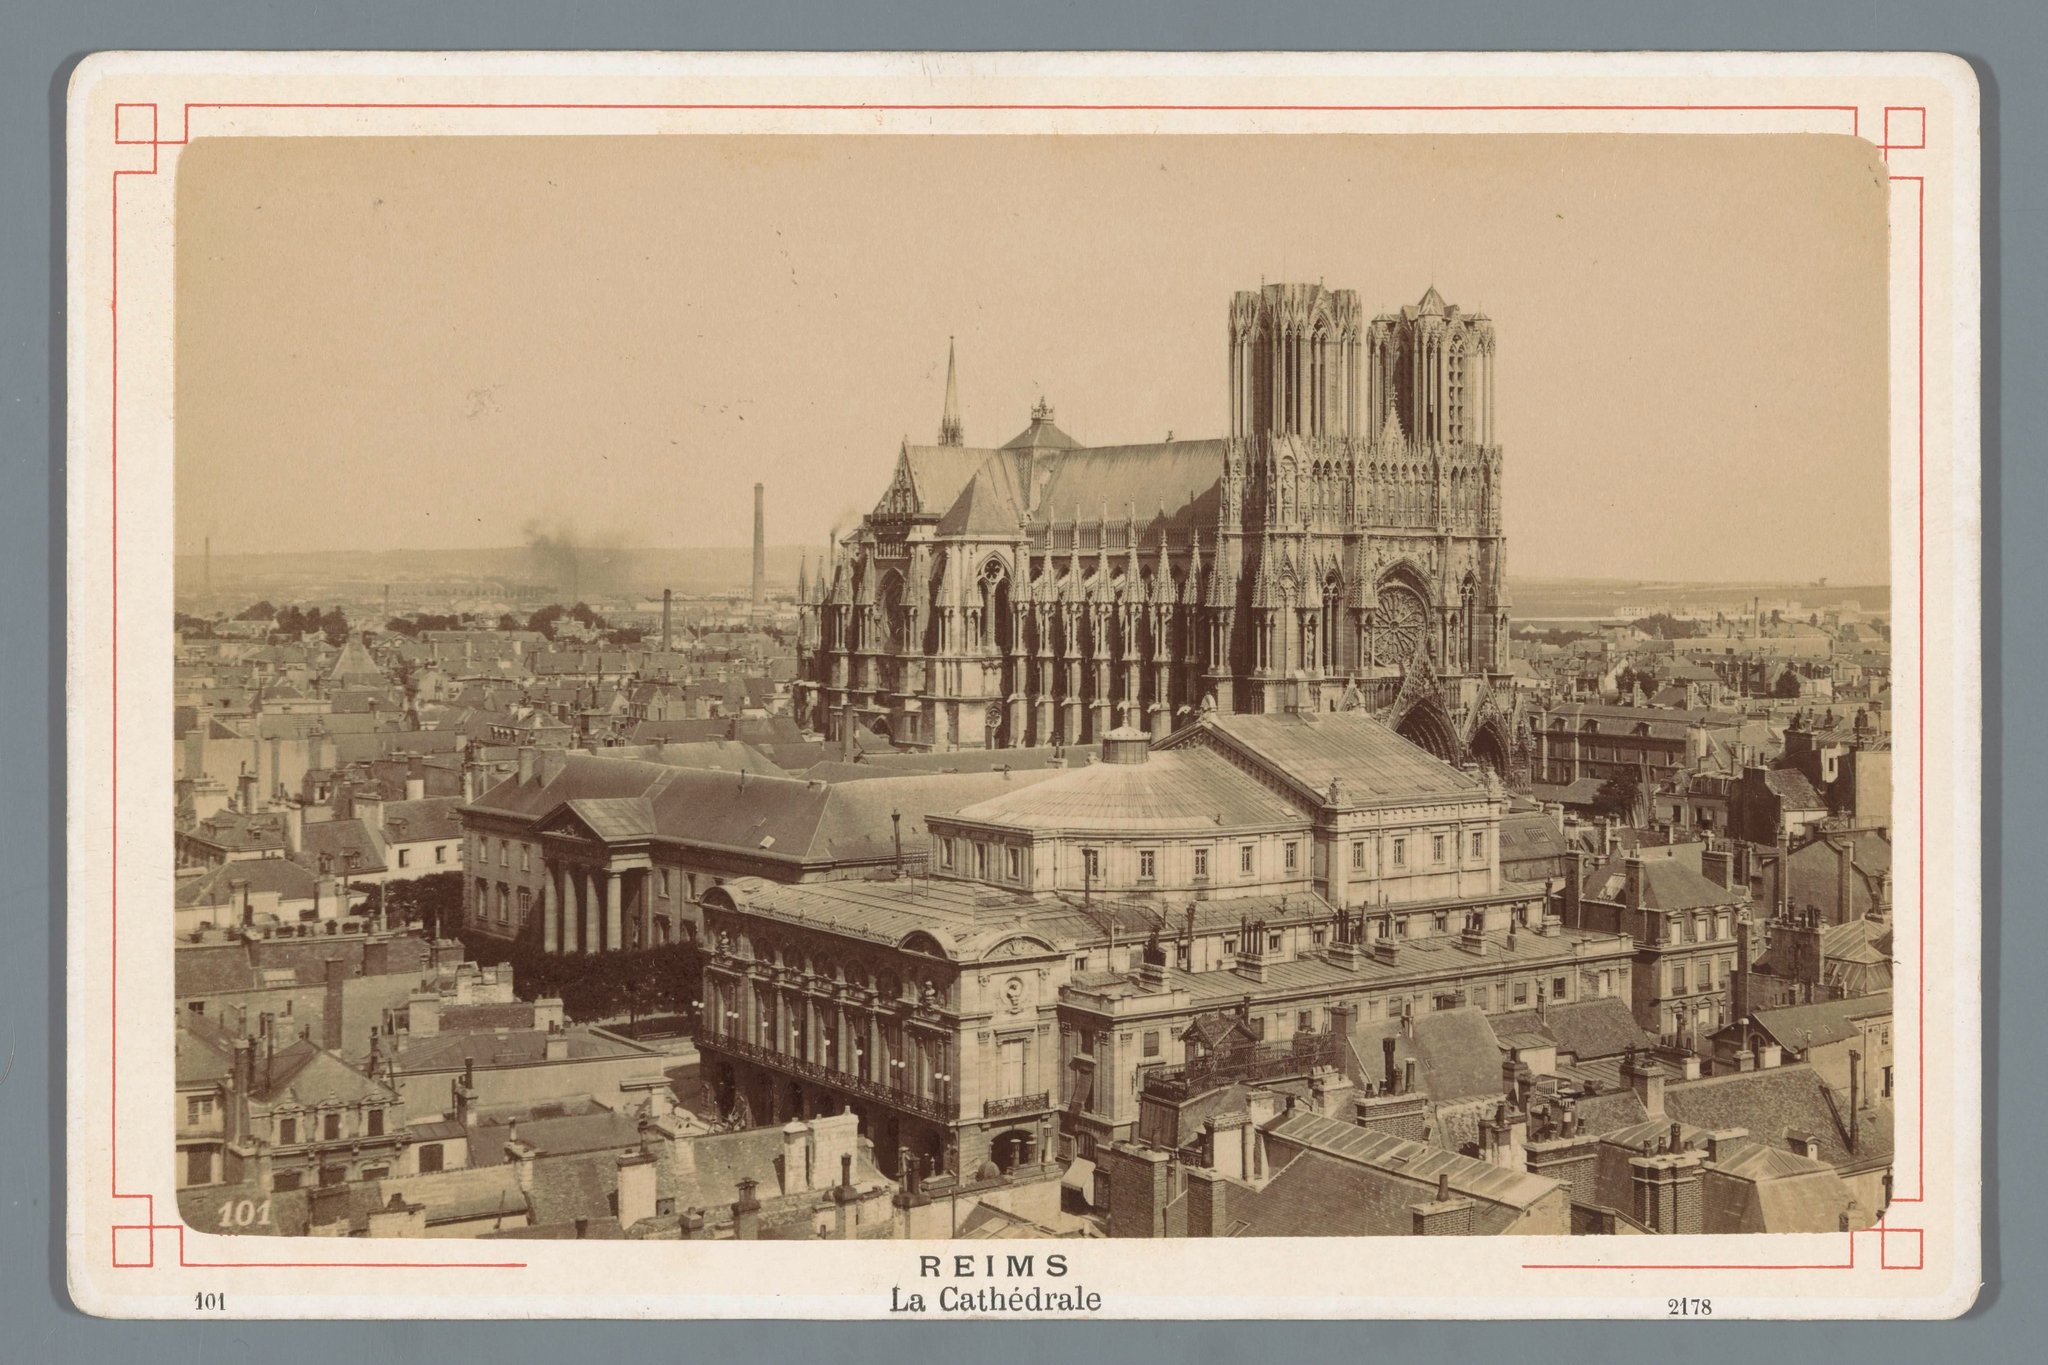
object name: cabinet photograph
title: Gezicht op Reims met de Kathedraal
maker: étienne neurdein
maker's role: publisher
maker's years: 1832-1918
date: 1870-1900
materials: cardboard, photographic support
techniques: albumen print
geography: reims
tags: city-view in general; 'veduta', church (exterior)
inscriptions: number: ‘101/ 2178’, number: ‘101’